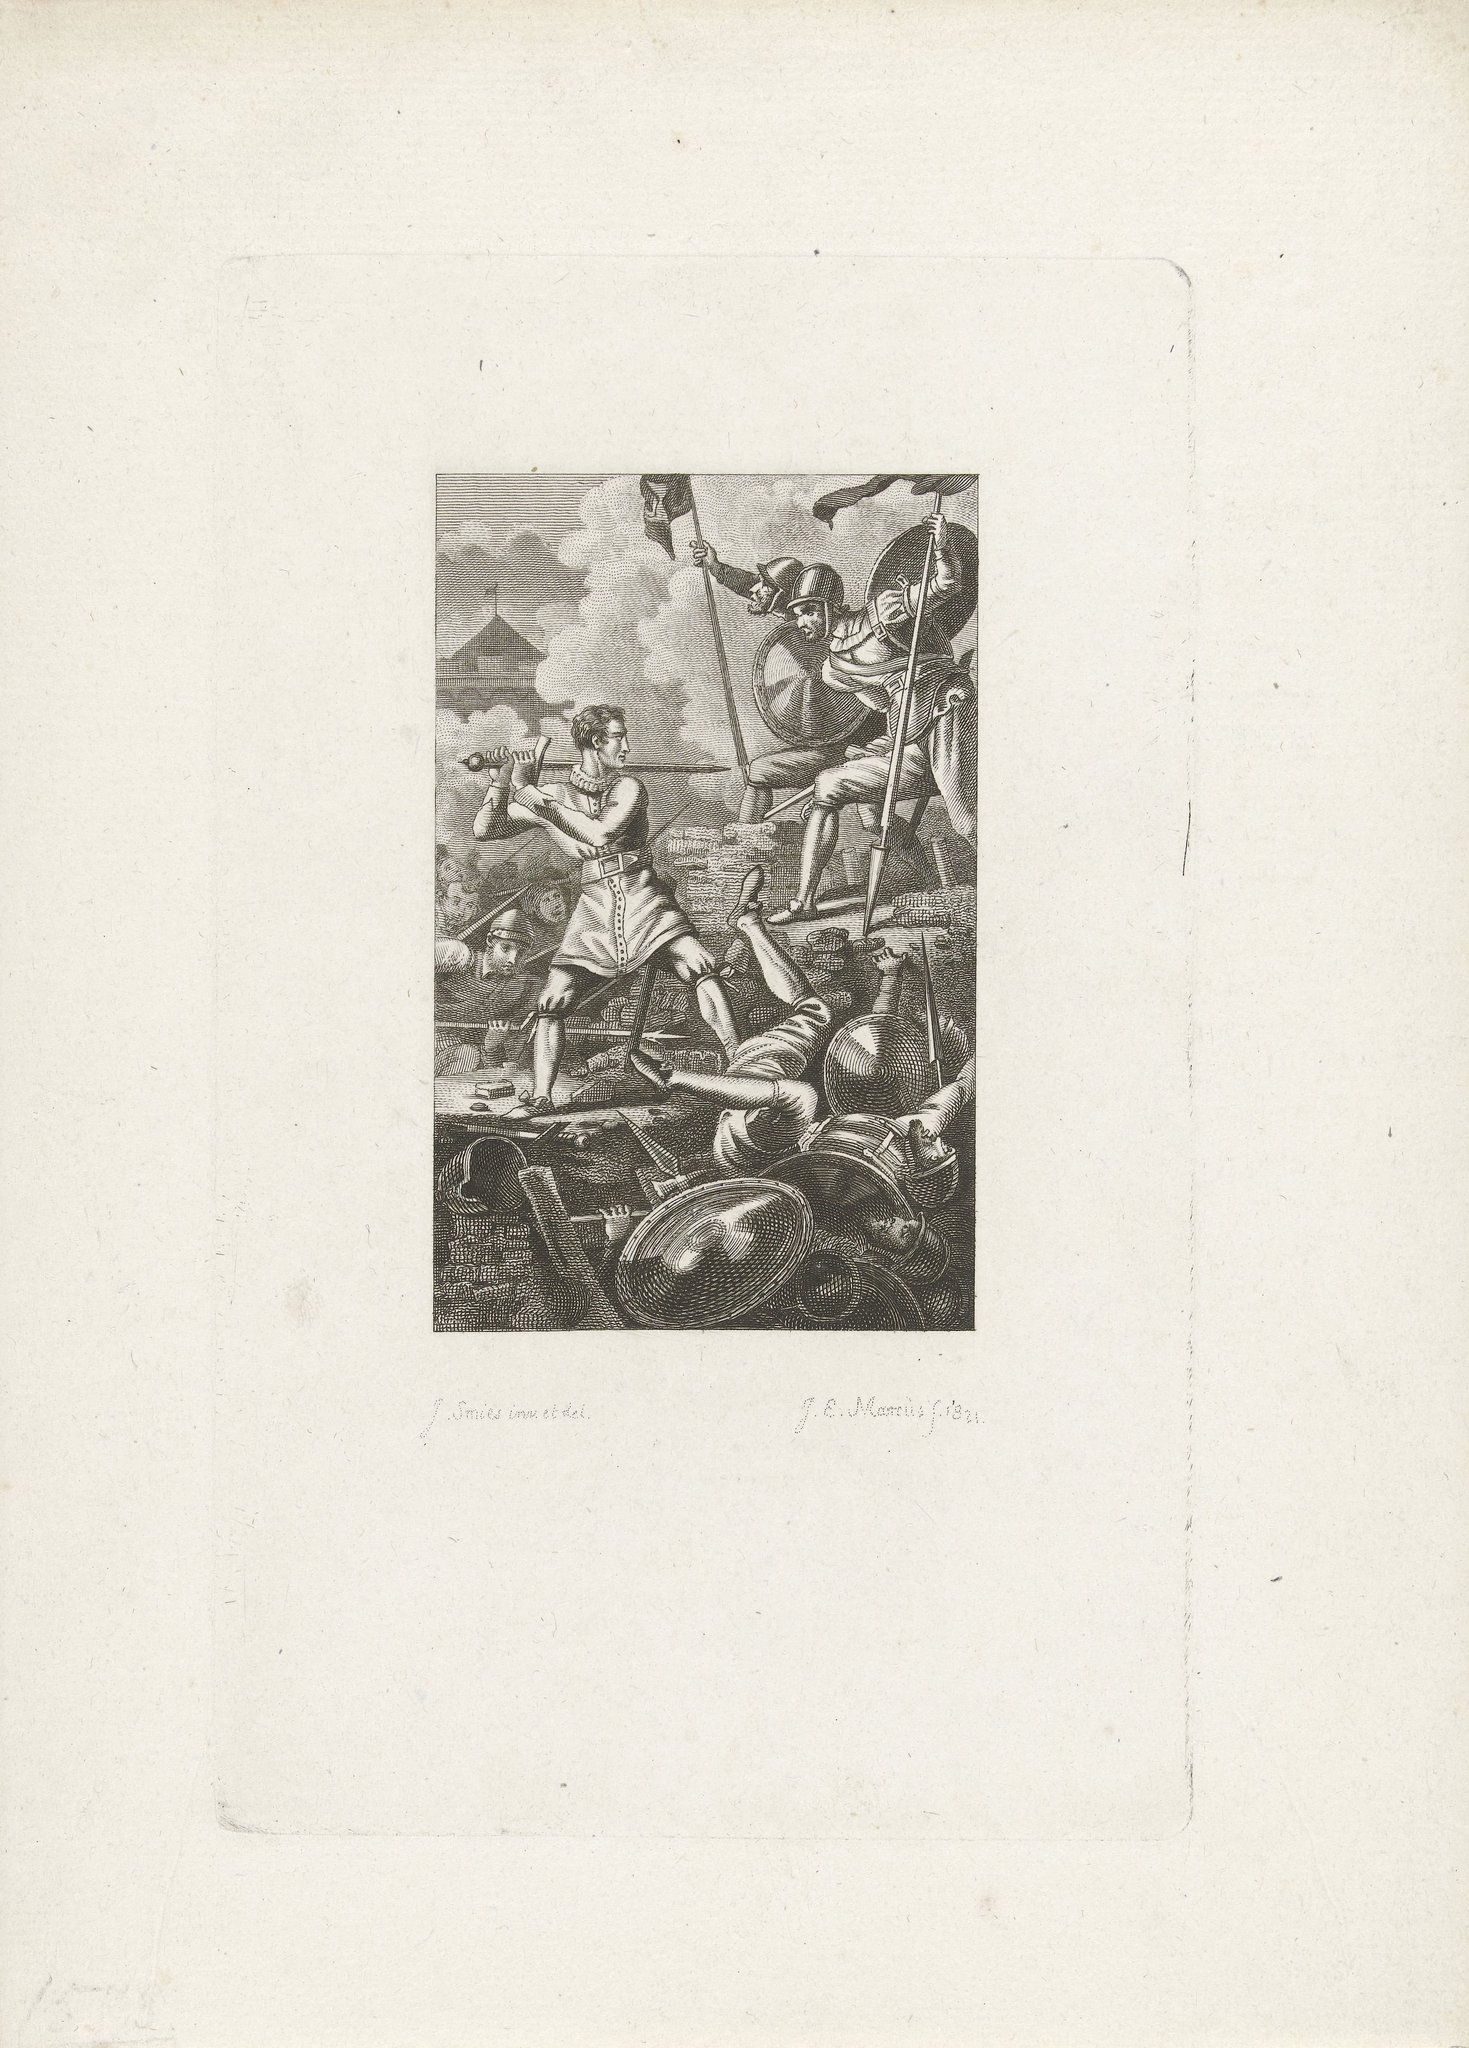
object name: print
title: Beleg van Alkmaar, 1573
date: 1821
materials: paper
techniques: etching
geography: netherlands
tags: defence ~ siege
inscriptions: date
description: Illustratie voor: P.C. Hoofts Nederlandsche historien / met aanteekn. en ophelderingen van M. Siegenbeek, A. Simons en J.P. van Cappelle. J. van der Hey, Amsterdam 1820-1824.